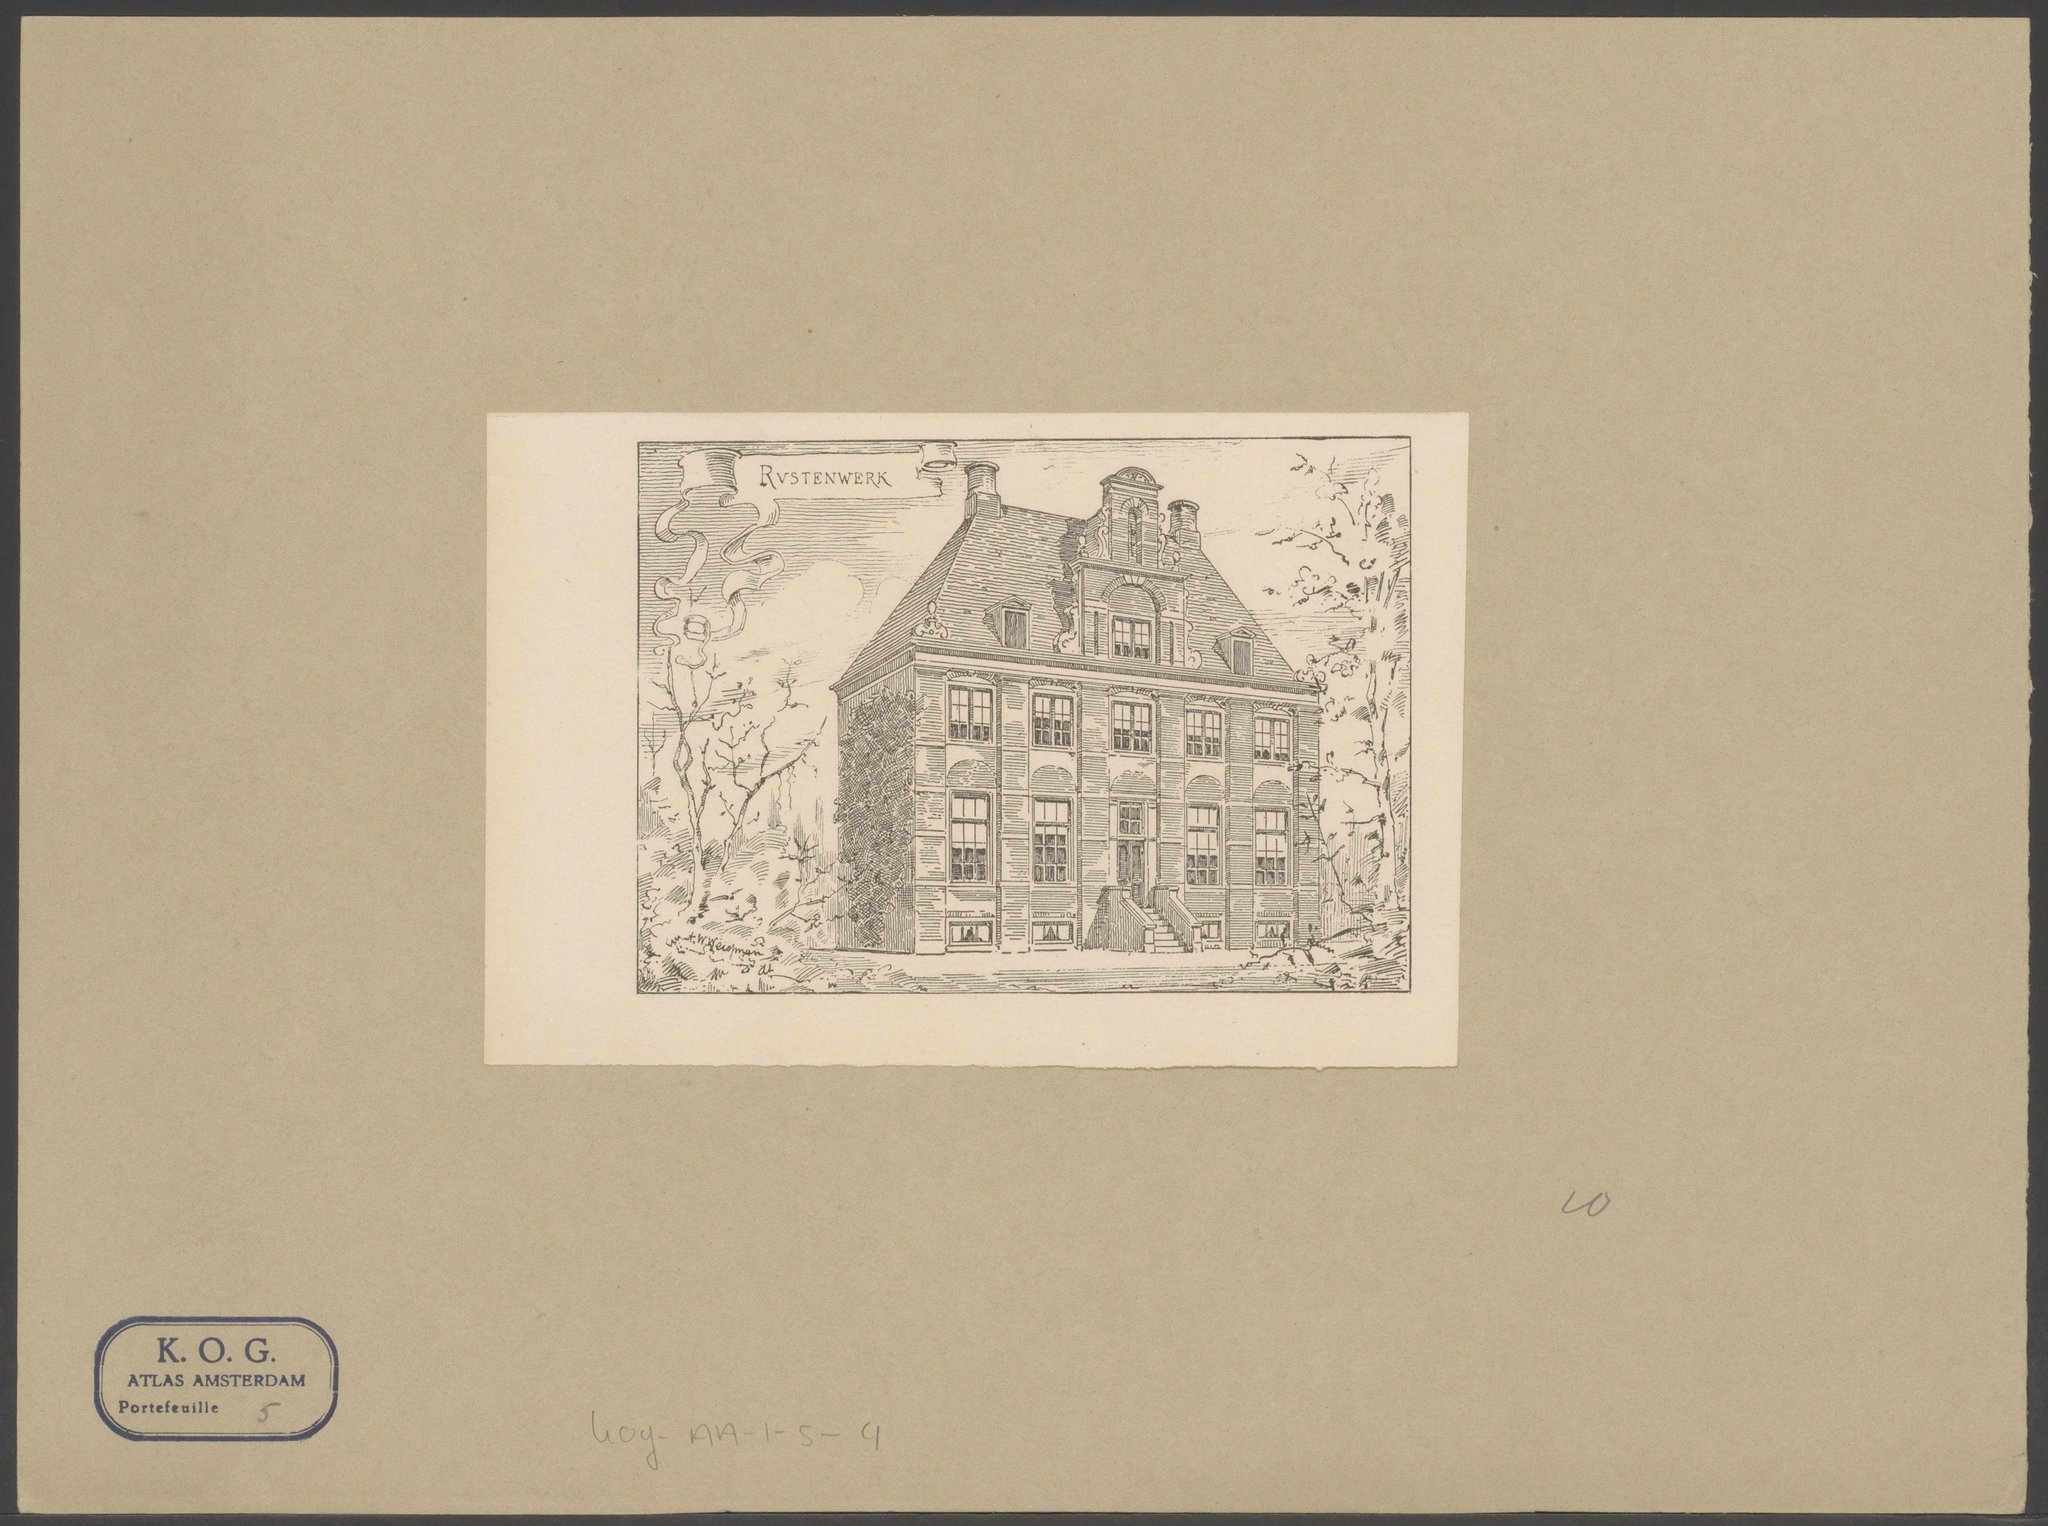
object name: photomechanical print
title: Gezicht op buitenplaats Rust en Werk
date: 1875-1950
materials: paper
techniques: line block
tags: city-view in general; 'veduta', rural housing, e.g. country-house, villa, cottage, façade (of house or building)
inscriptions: collector's mark: ‘5’ Lugt 1641b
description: Onderwerpsrubriek binnen de Atlas Amsterdam: Amstel buiten de stad, Amsteldijk.